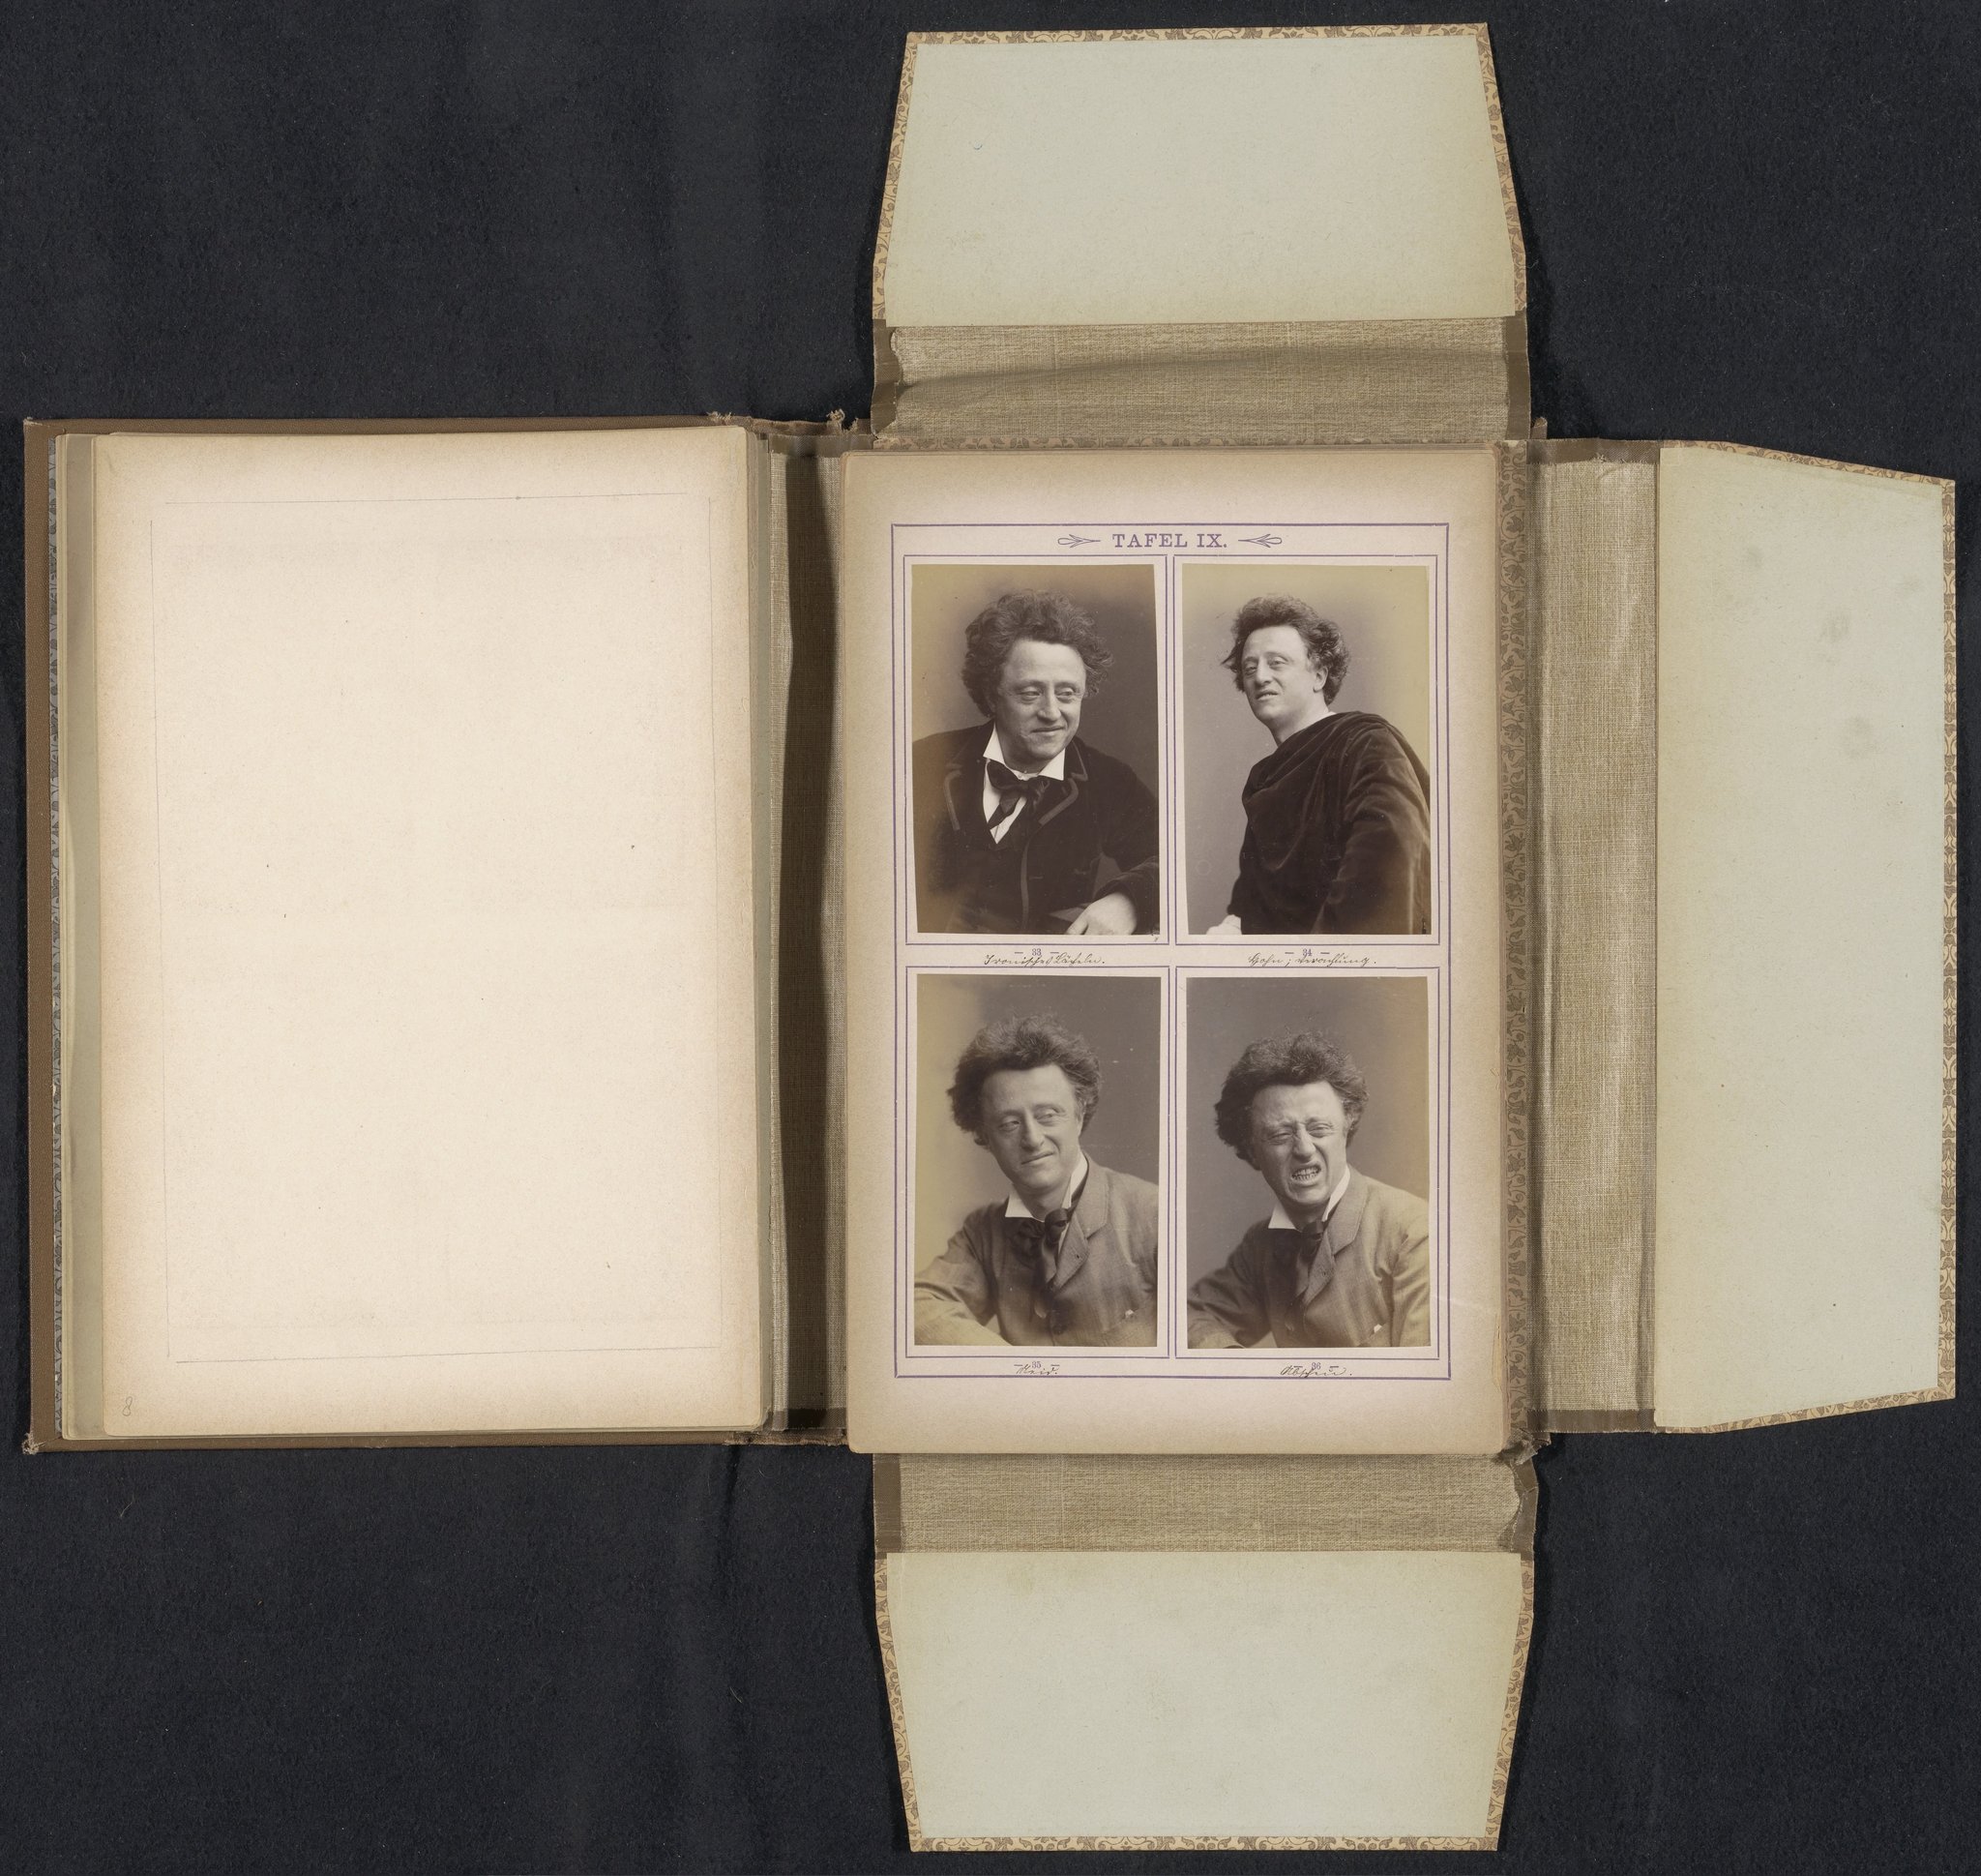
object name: photograph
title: Vier portretten van een man met gezichtsuitdrukkingen van ironisch lachen, minachting, afgunst en walging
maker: nicola tonger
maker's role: fotograaf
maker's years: 1846-1917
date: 1881-1886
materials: cardboard, photographic support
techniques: albumen print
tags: aversion, morphology of facial expression, physiognomy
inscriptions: number: ‘33 (...) 36’, inscription: ‘Ironisches Lächeln (...) Abscheu.’, number: ‘Tafel IX.’